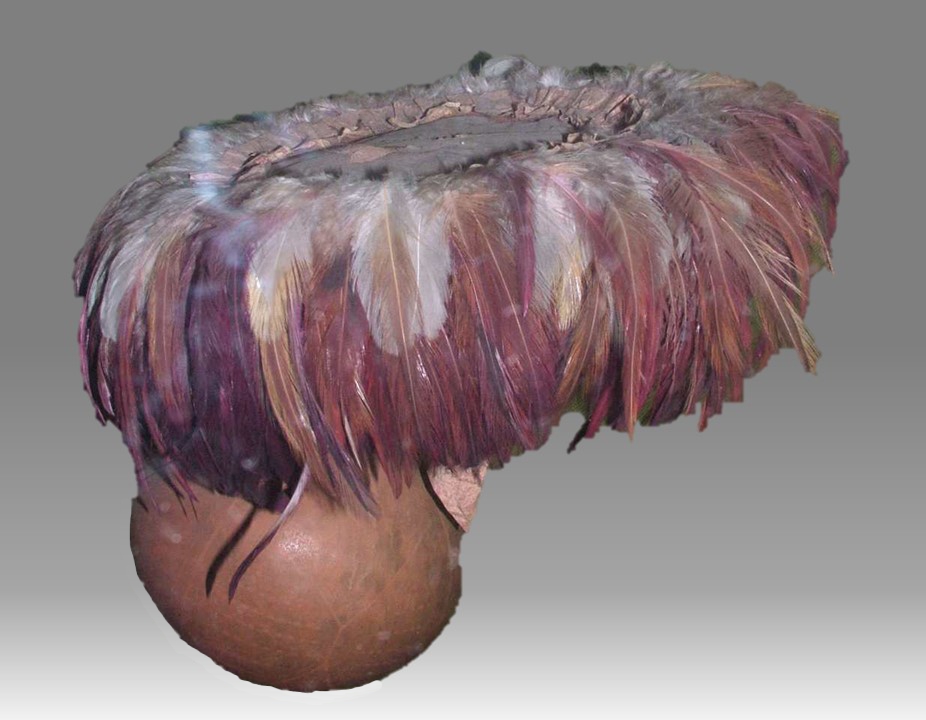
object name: 'uli'uli rattle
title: 'Uli'Uli (rattle)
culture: hawaiian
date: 1801-1900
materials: feather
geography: united states